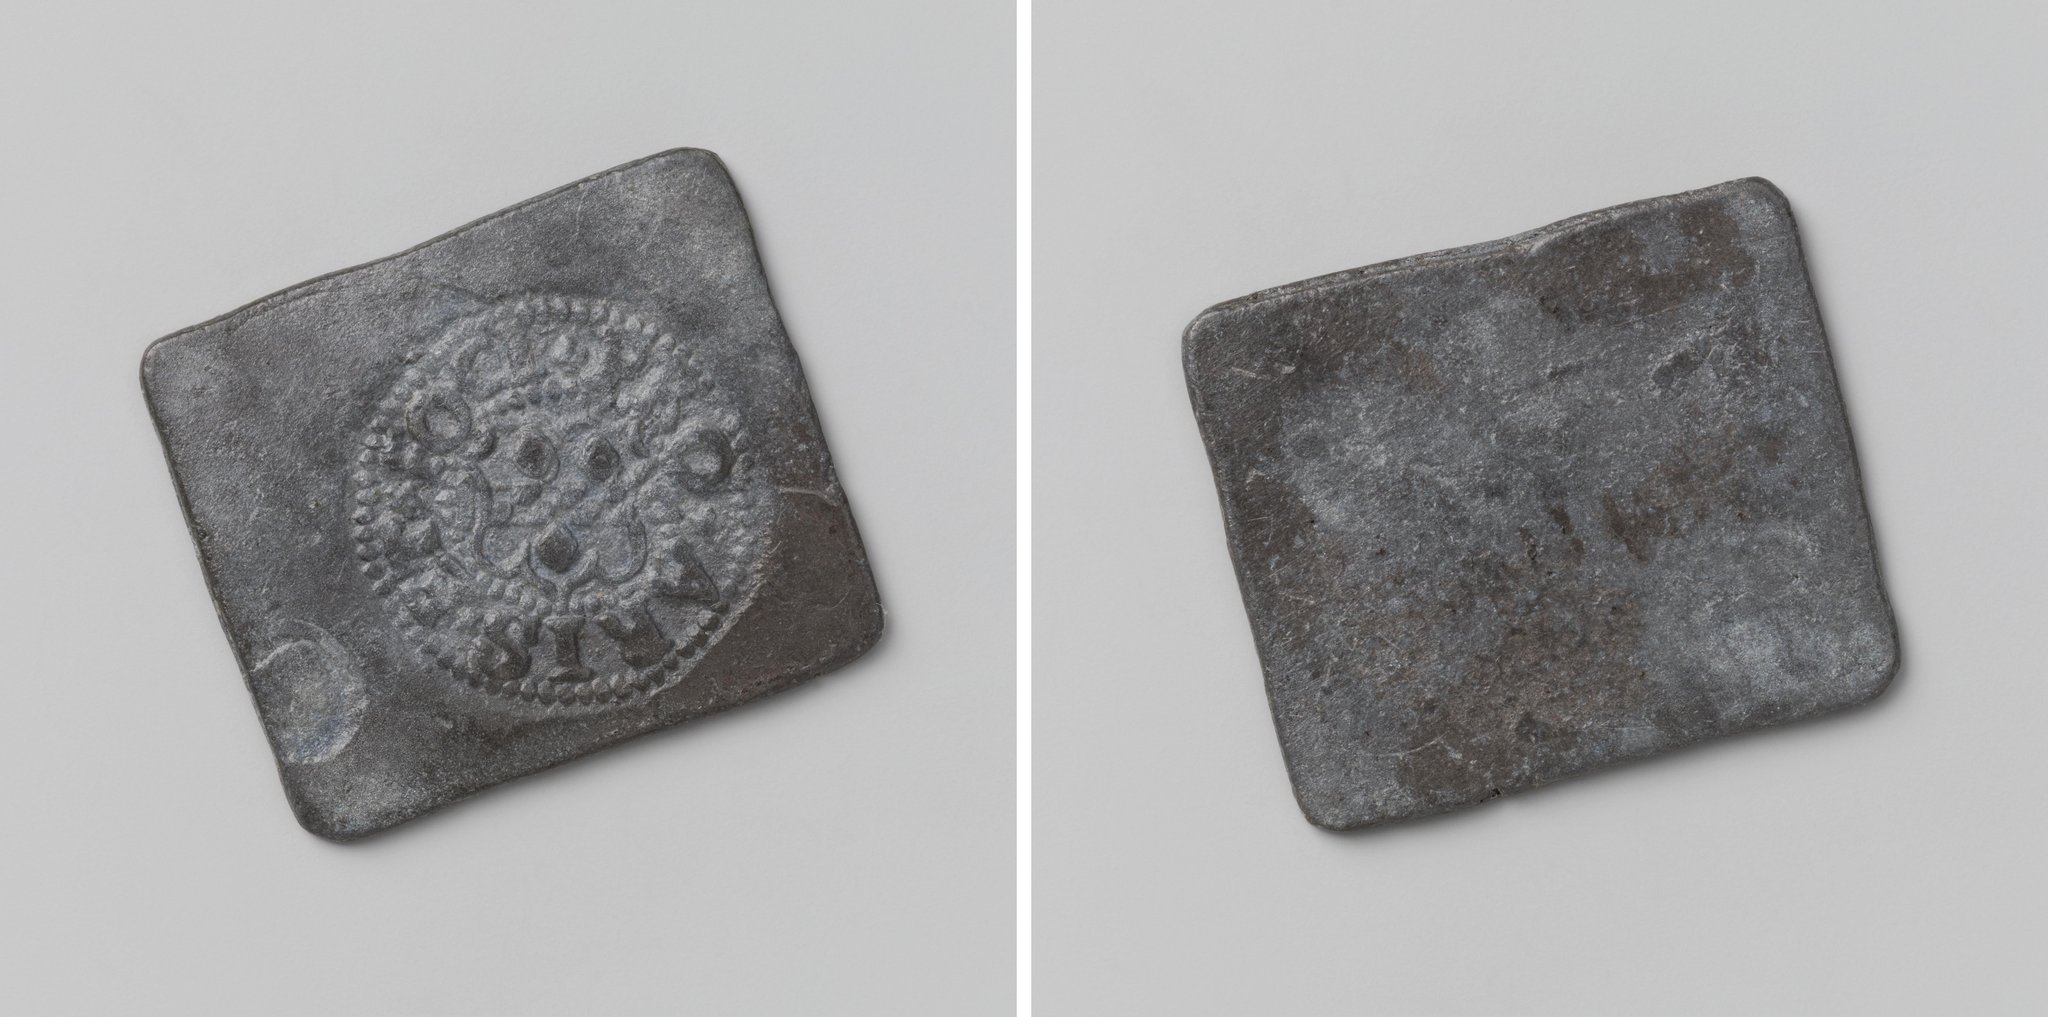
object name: tien stuiver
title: Tien stuiver, noodmunt uit Woerden, geslagen tijdens het beleg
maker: Anonymous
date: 1575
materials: tin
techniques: striking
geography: woerden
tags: woerden, tachtigjarige oorlog, beleg van woerden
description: eenzijdige, ruitvormige noodmunt. Voorzijde: wapenschild tussen cijfers 1 en 0 binnen omschrift en parelrand; daaronder mogelijk nog stempeltje [?]. Keerzijde: blanco